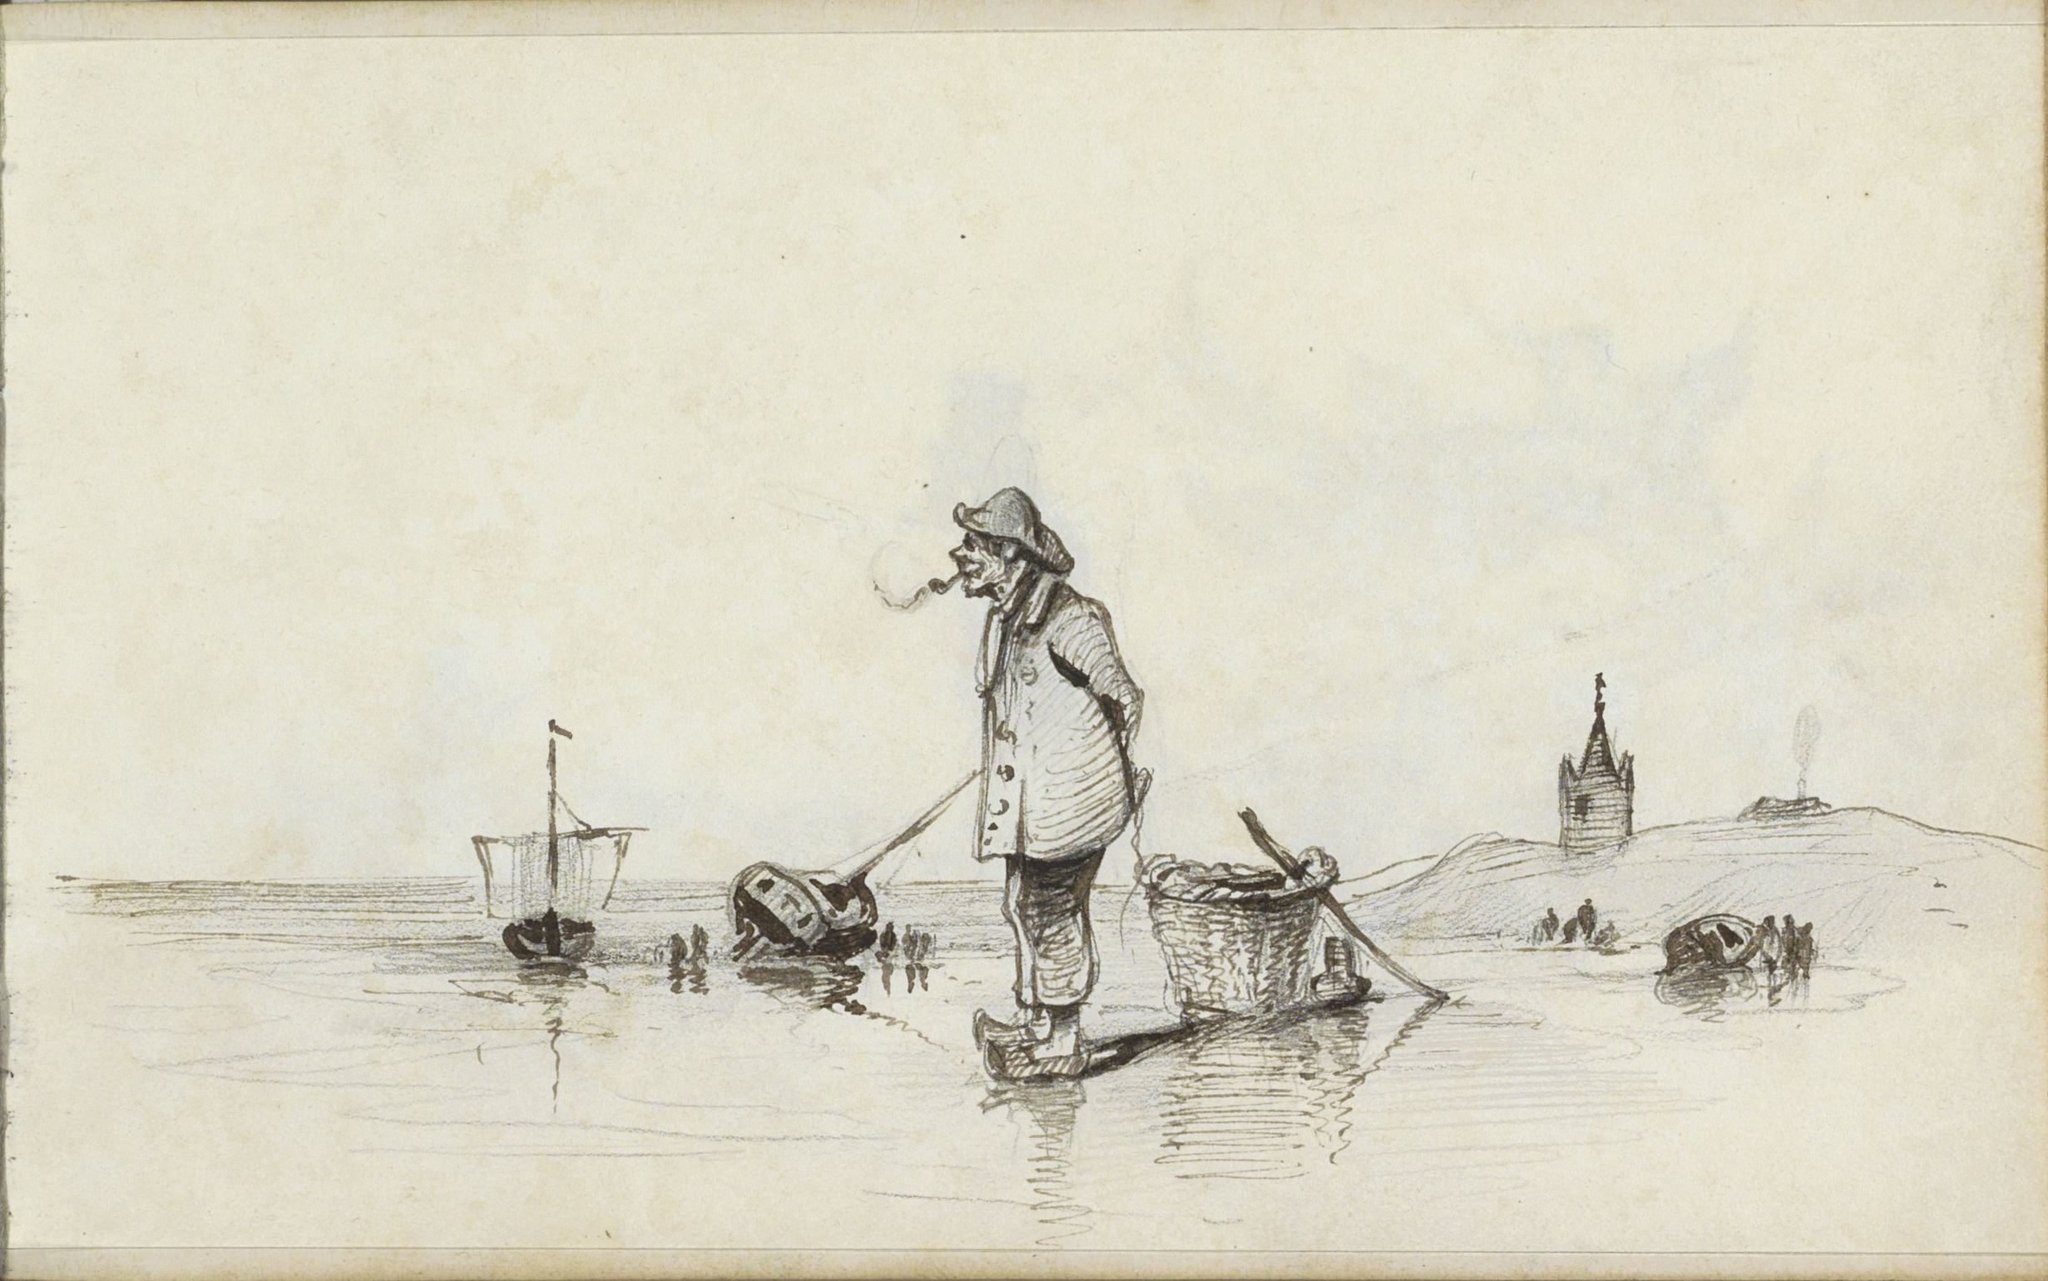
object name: sketchbook leaf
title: Pijprokende man aan de vloedlijn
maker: johannes tavenraat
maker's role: draughtsman, painter, print maker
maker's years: 1809-1881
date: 1843-1844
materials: ink, paper, pencil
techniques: pen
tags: sailing-ship, sailing-boat, landscapes with waters, waterscapes, seascapes (in the temperate zone), container made of plant material other than wood: basket, church (exterior)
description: Naast de man staat een rieten mand. Op zee enkele zeilschepen en op de achtergrond een kerktoren. Blad 13 recto uit een schetsboek met 38 bladen.